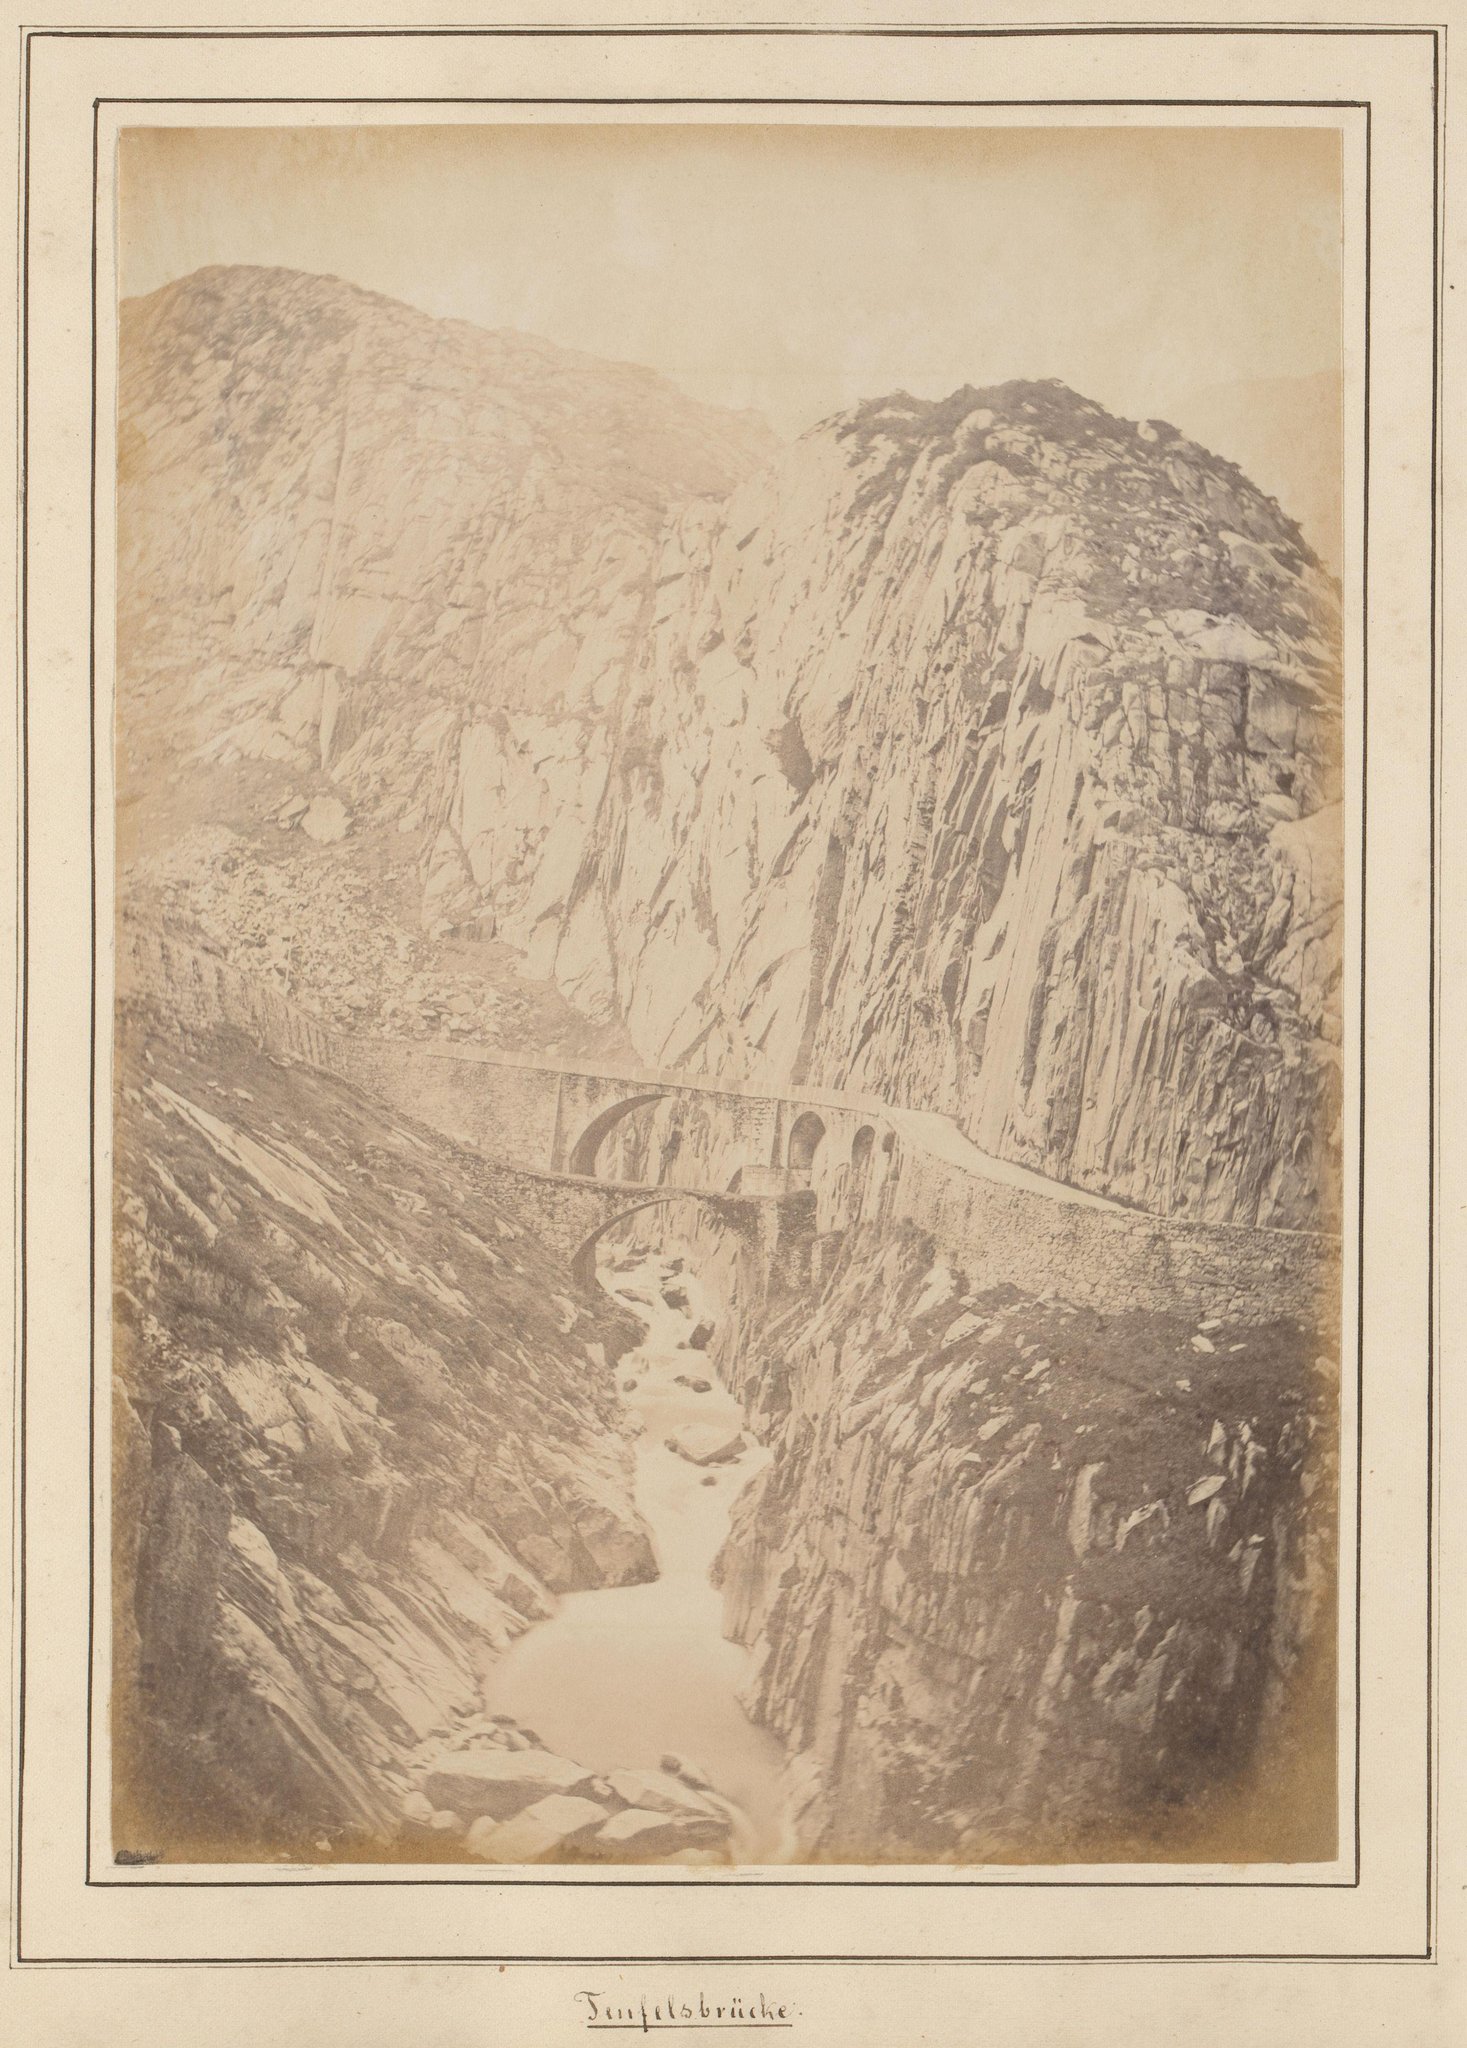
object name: photograph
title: Teufelsbrücke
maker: Anonymous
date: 1870-1890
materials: paper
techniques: albumen print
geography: teufelsbrücke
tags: bridge